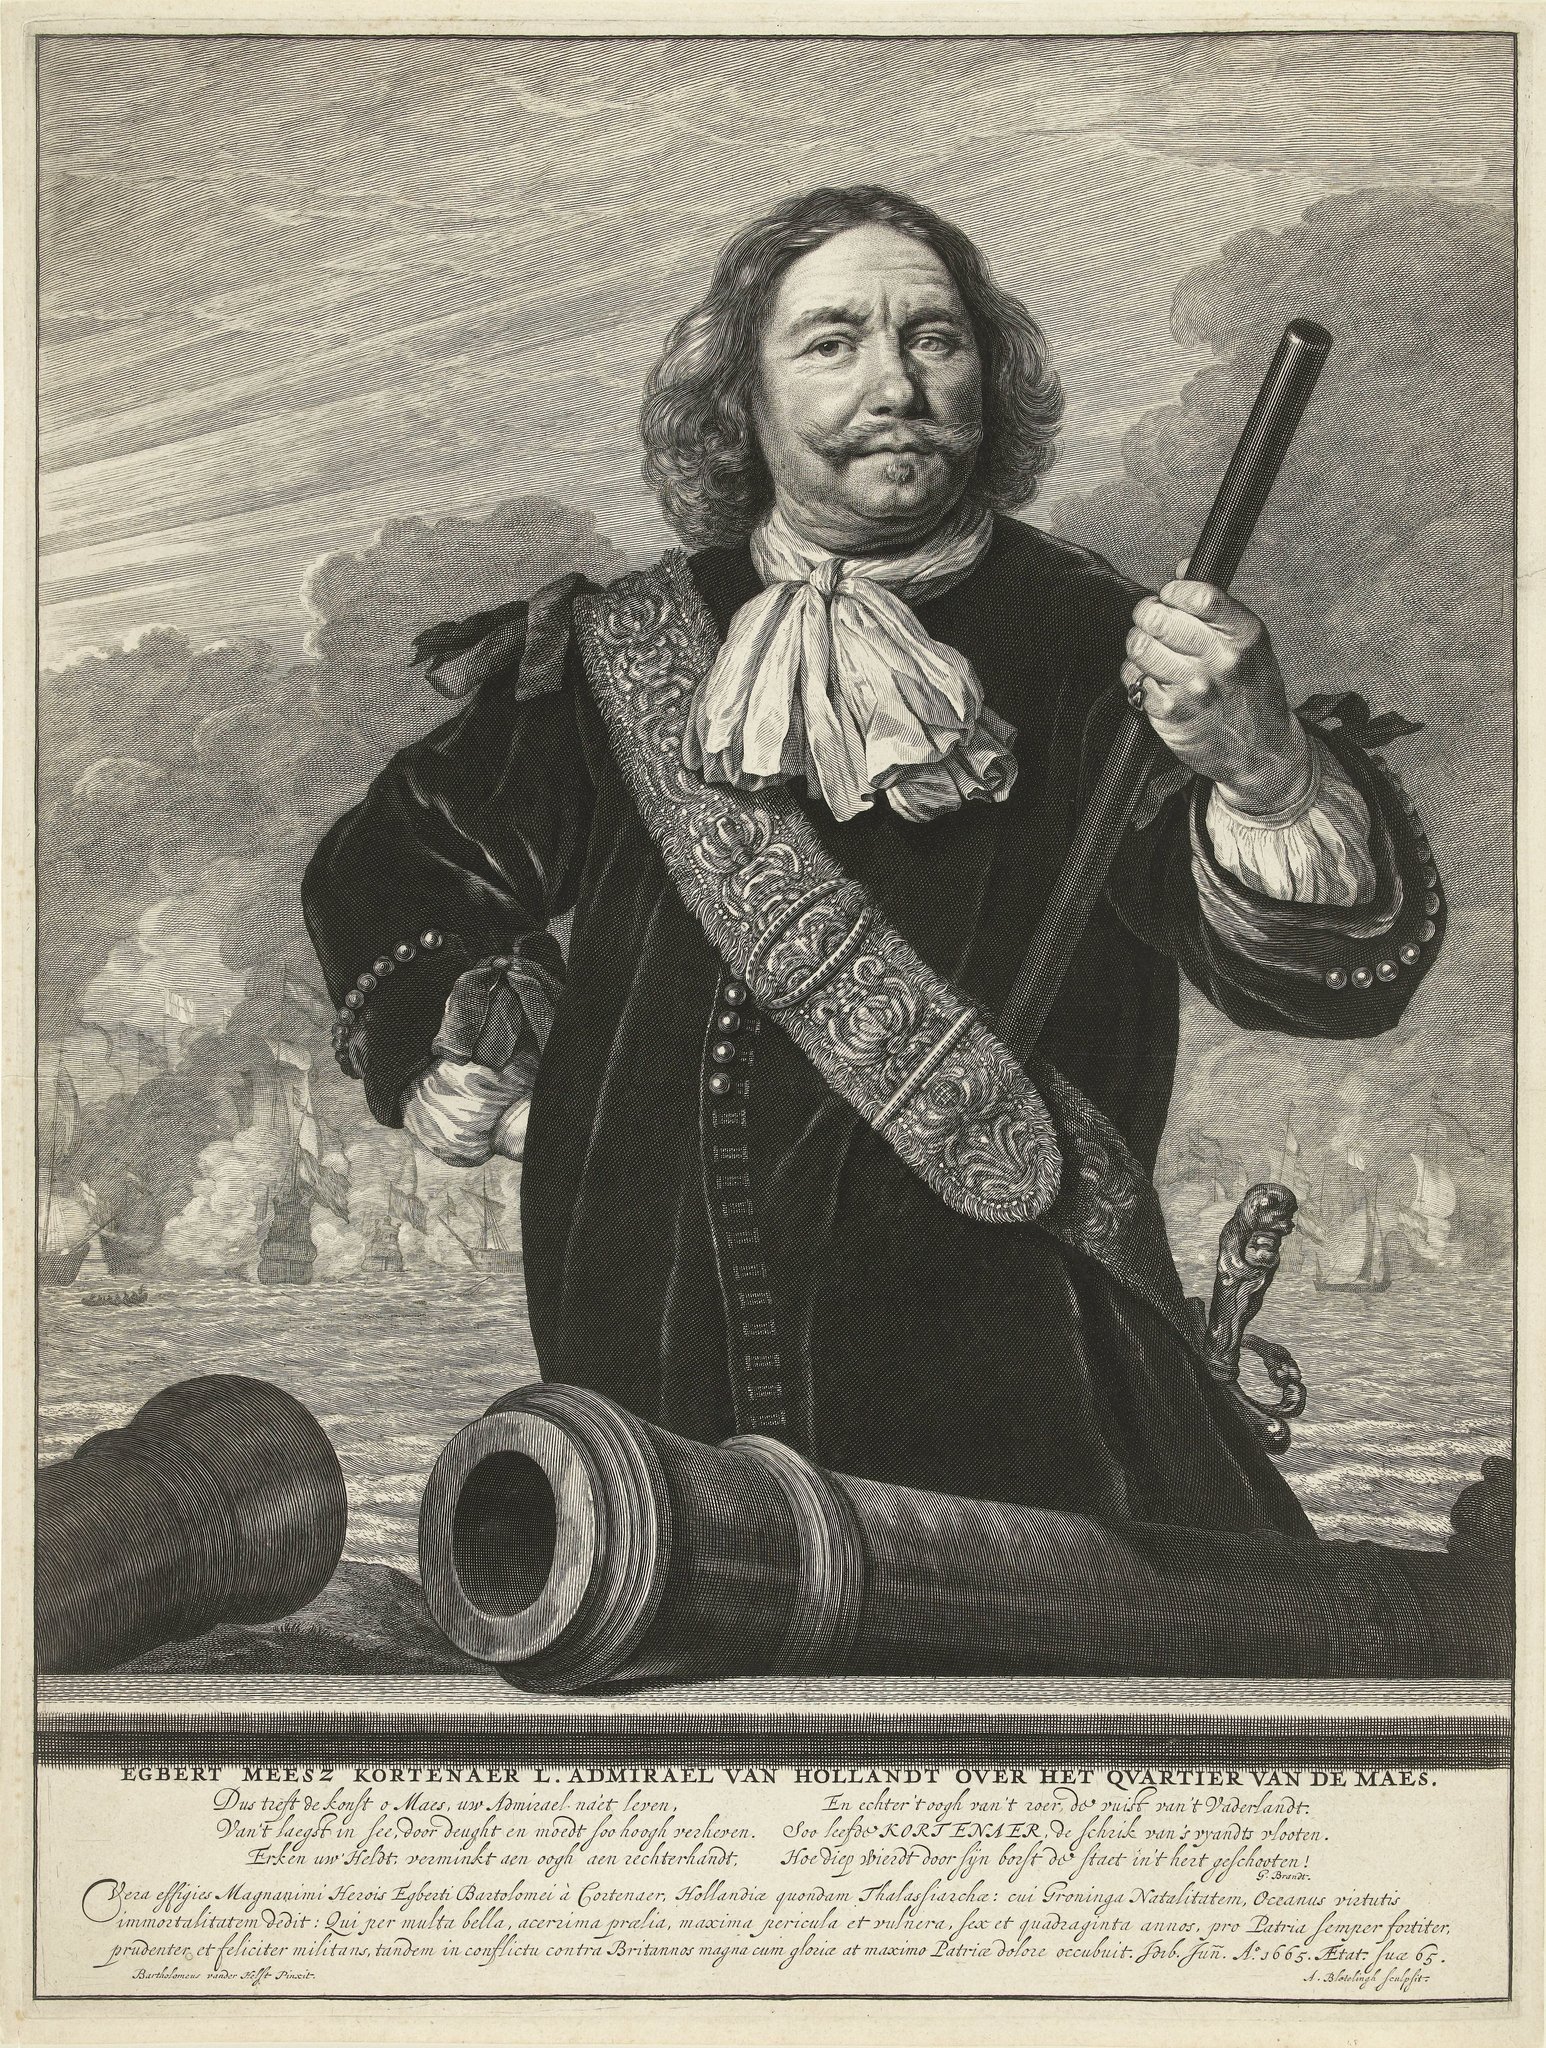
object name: print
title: Portret van admiraal Egbert Meeuwisz. Kortenaer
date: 1665-1672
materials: paper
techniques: engraving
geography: amsterdam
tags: commander-in-chief, admiral (+ naval force)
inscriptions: collector's mark: Lugt 240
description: Portret van admiraal Egbert Meeuwisz. Kortenaer. Kortenaer was een luitenant-admiraal die zich vooral in de Engelse oorlogen had bewezen. Tijdens de zogenoemde slag bij de Singels raakte hij gewond en verloor een hand en een oog. Deze verwondingen versterkten juist zijn heldenstatus en in het lofdicht onder de prent wordt ook hiernaar verwezen. Kortenaer staat met de commandostaf in zijn zij voor een zeeslag. Voor hem ligt een kanon.